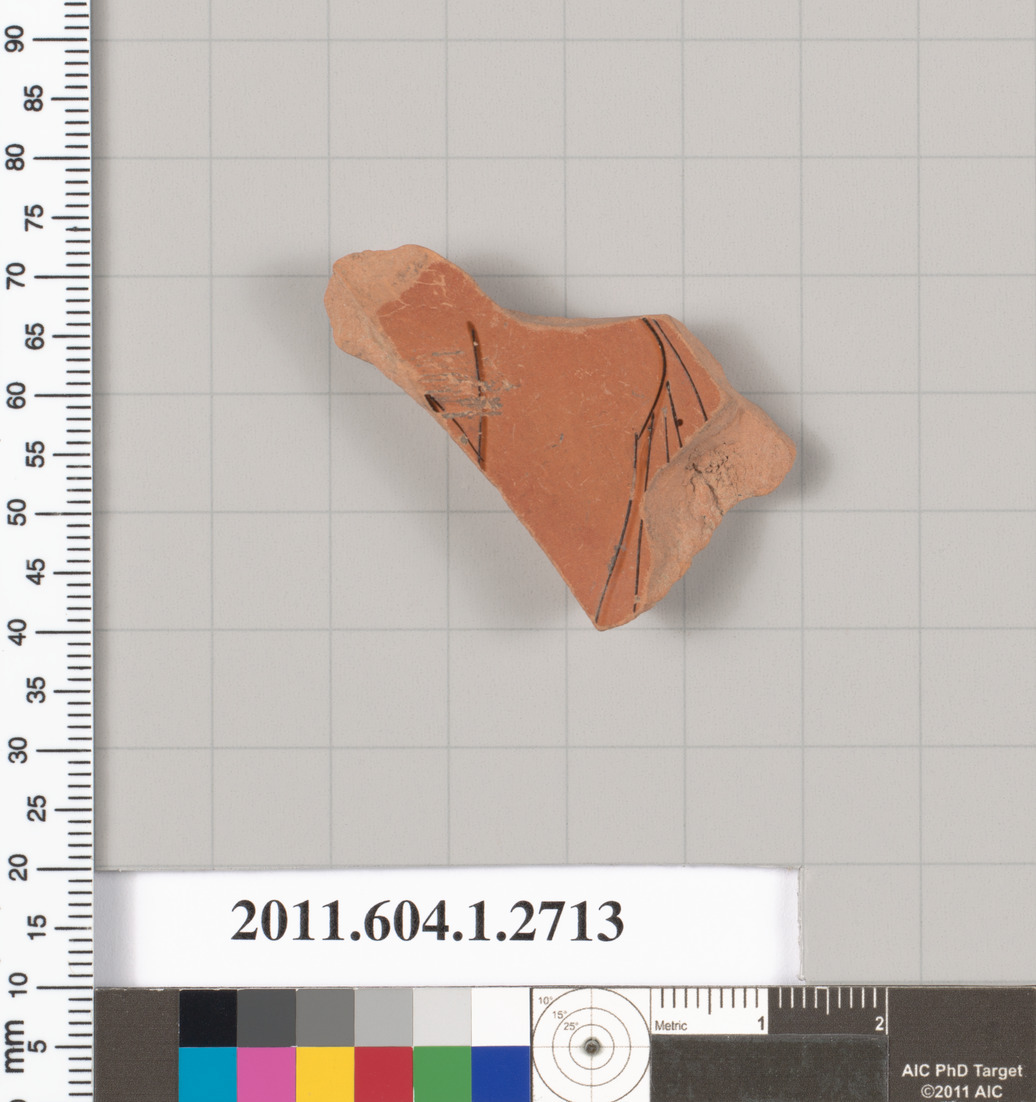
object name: kylix fragment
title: Terracotta fragment of a kylix (drinking cup)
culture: greek, attic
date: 490-480 BCE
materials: terracotta